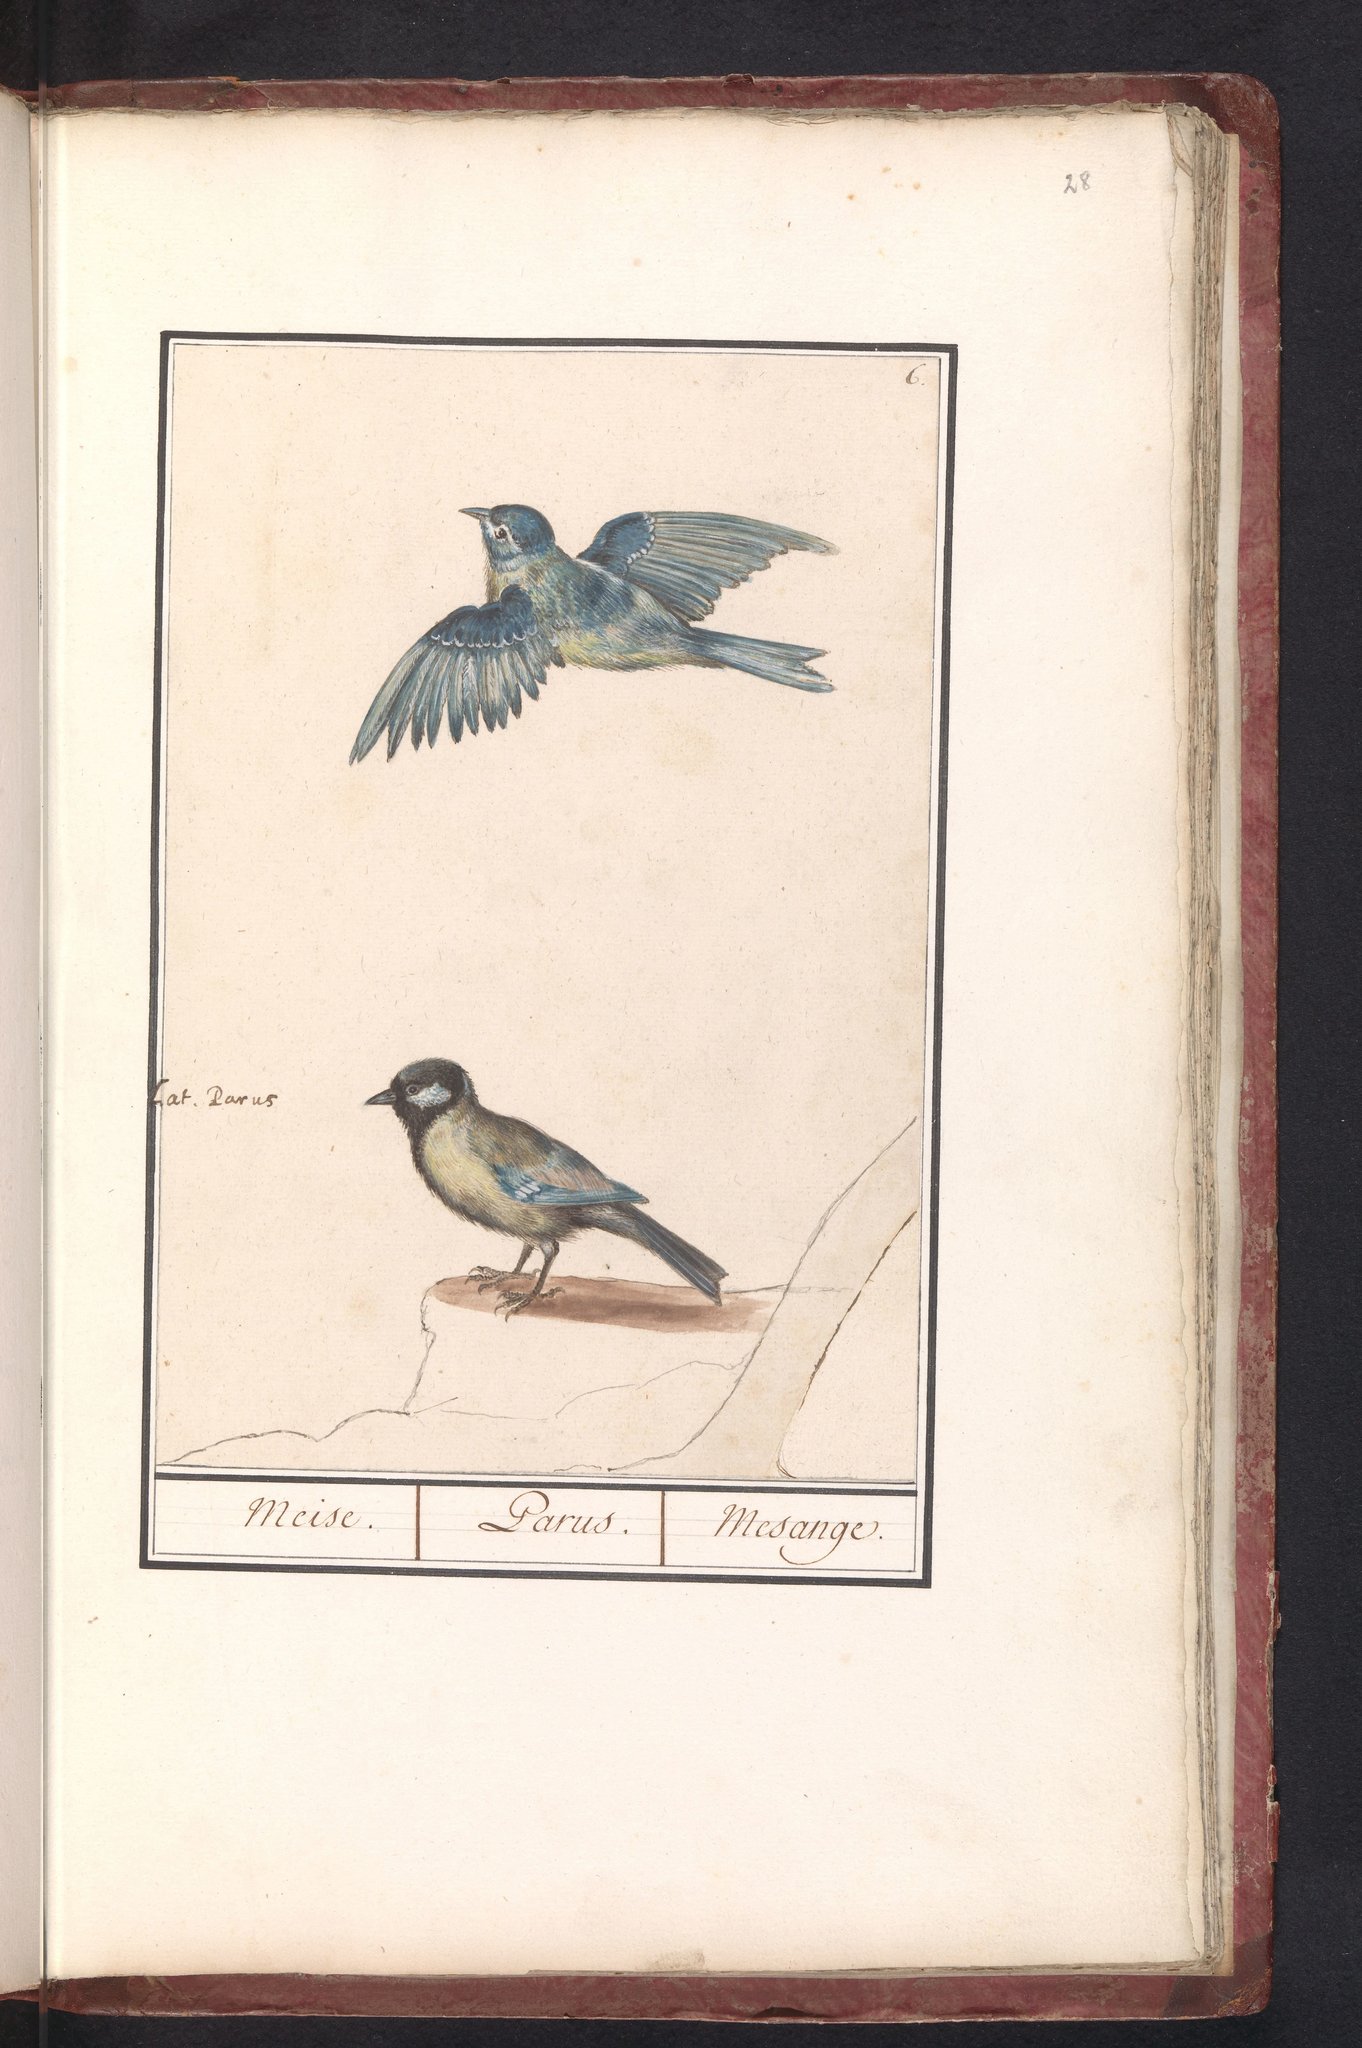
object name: drawing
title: Pimpelmees (Cyanistes caeruleus) en koolmees (Parus major)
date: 1596-1610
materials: paint, ink, paper, pencil, watercolor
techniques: brush, pen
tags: song-birds: blue tit, song-birds: great tit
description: Pimpelmees (vliegend) en koolmees. Genummerd rechtsboven: 6. Links de Latijnse naam. Onderdeel van het tweede album met tekeningen van vogels. Vierde van twaalf albums met tekeningen van dieren, vogels en planten bekend rond 1600, gemaakt in opdracht van keizer Rudolf II. Met toelichting in Nederlands, Latijn en Frans.